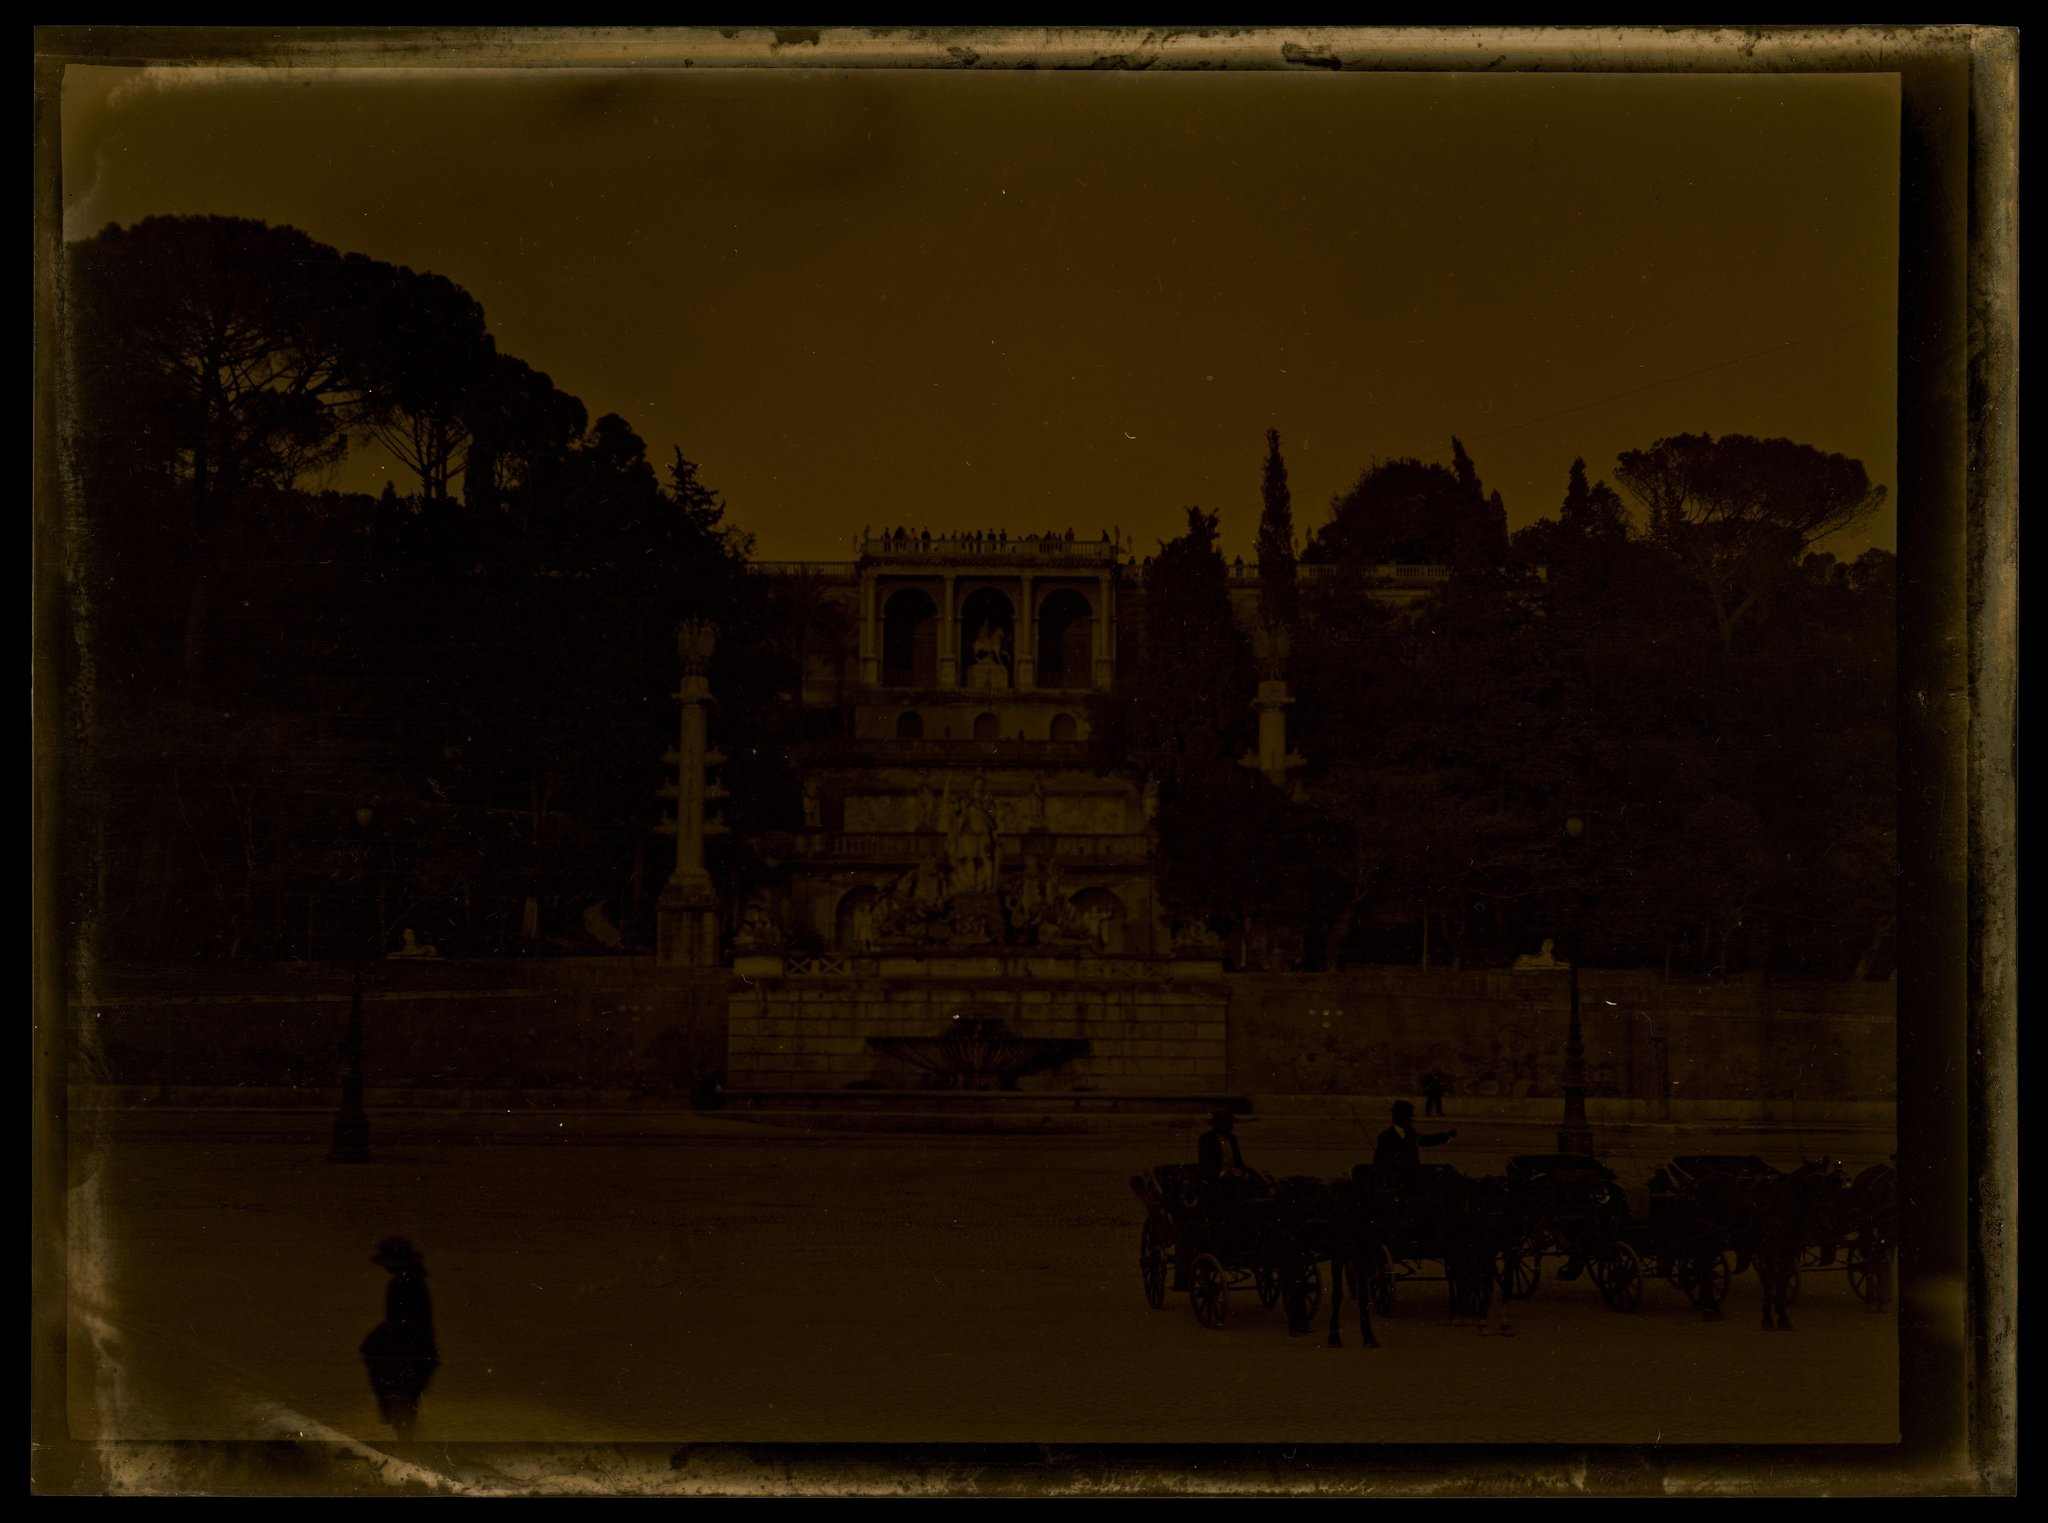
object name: photograph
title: Filmnegatief met opname van Rome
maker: Anonymous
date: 1907-1935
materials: film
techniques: gelatin silver negative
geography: rome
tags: rome